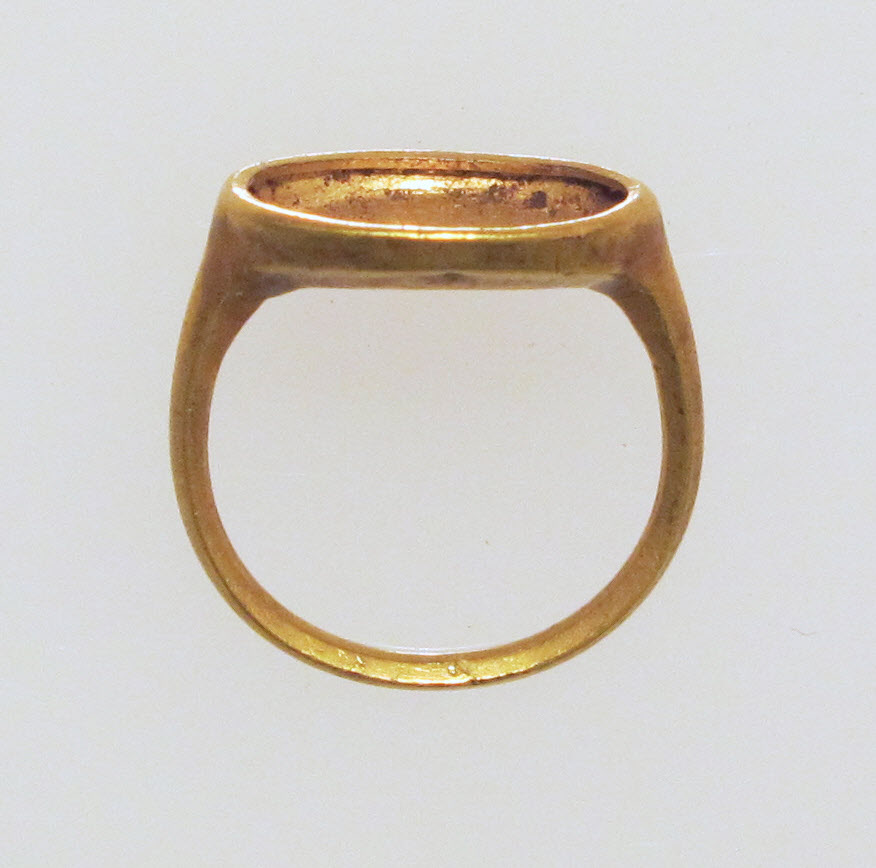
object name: ring with box setting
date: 7000 BCE-330 CE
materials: gold